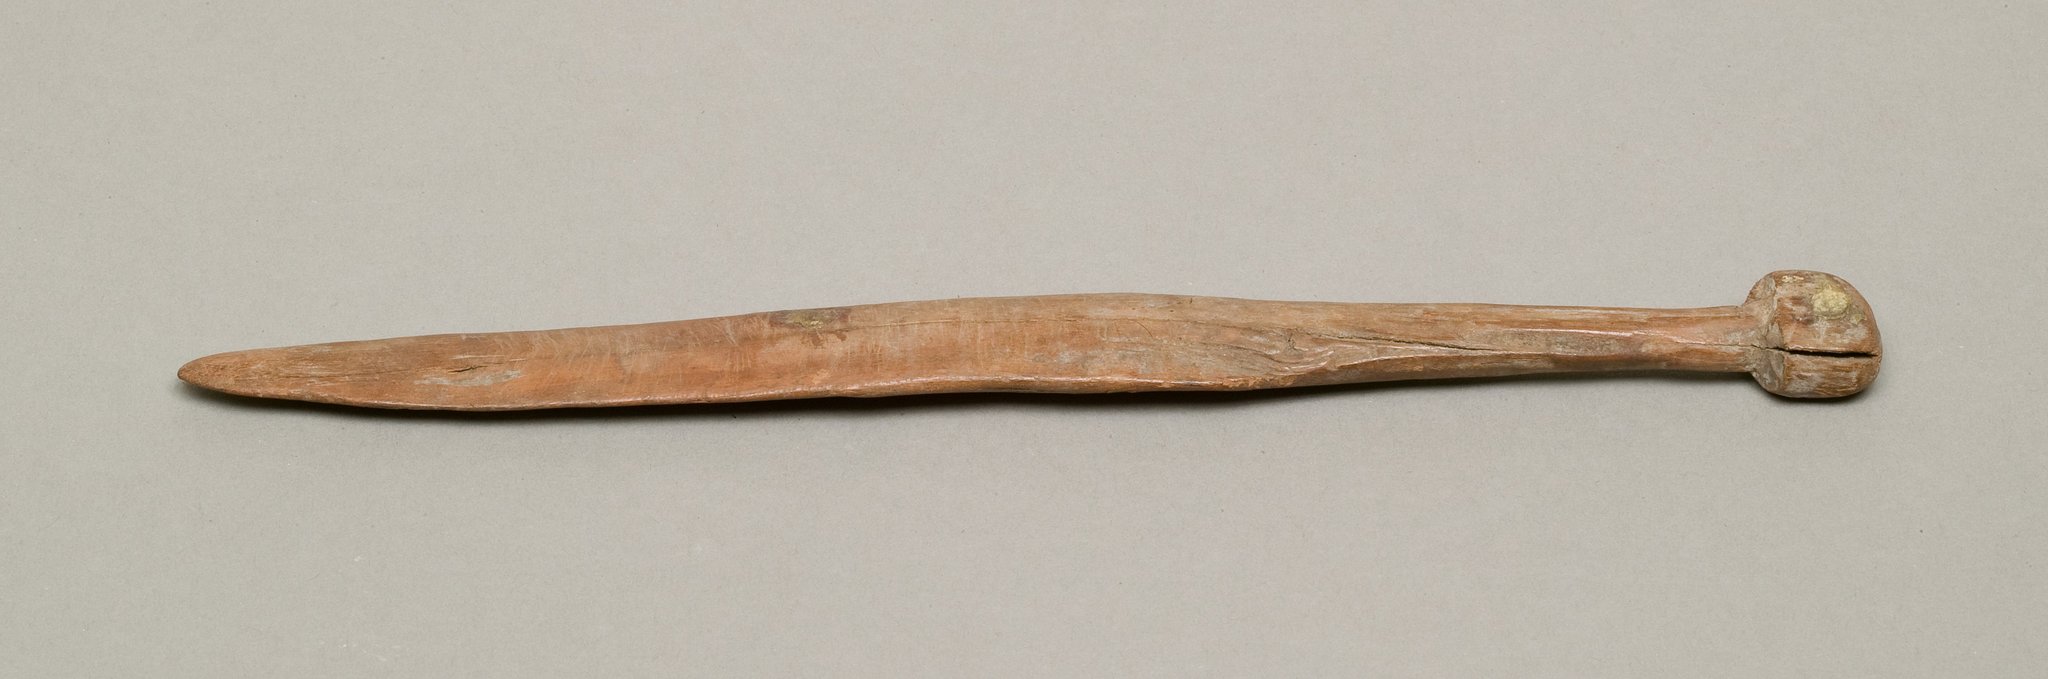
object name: weaving tool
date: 1295-1070 BCE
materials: wood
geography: egypt